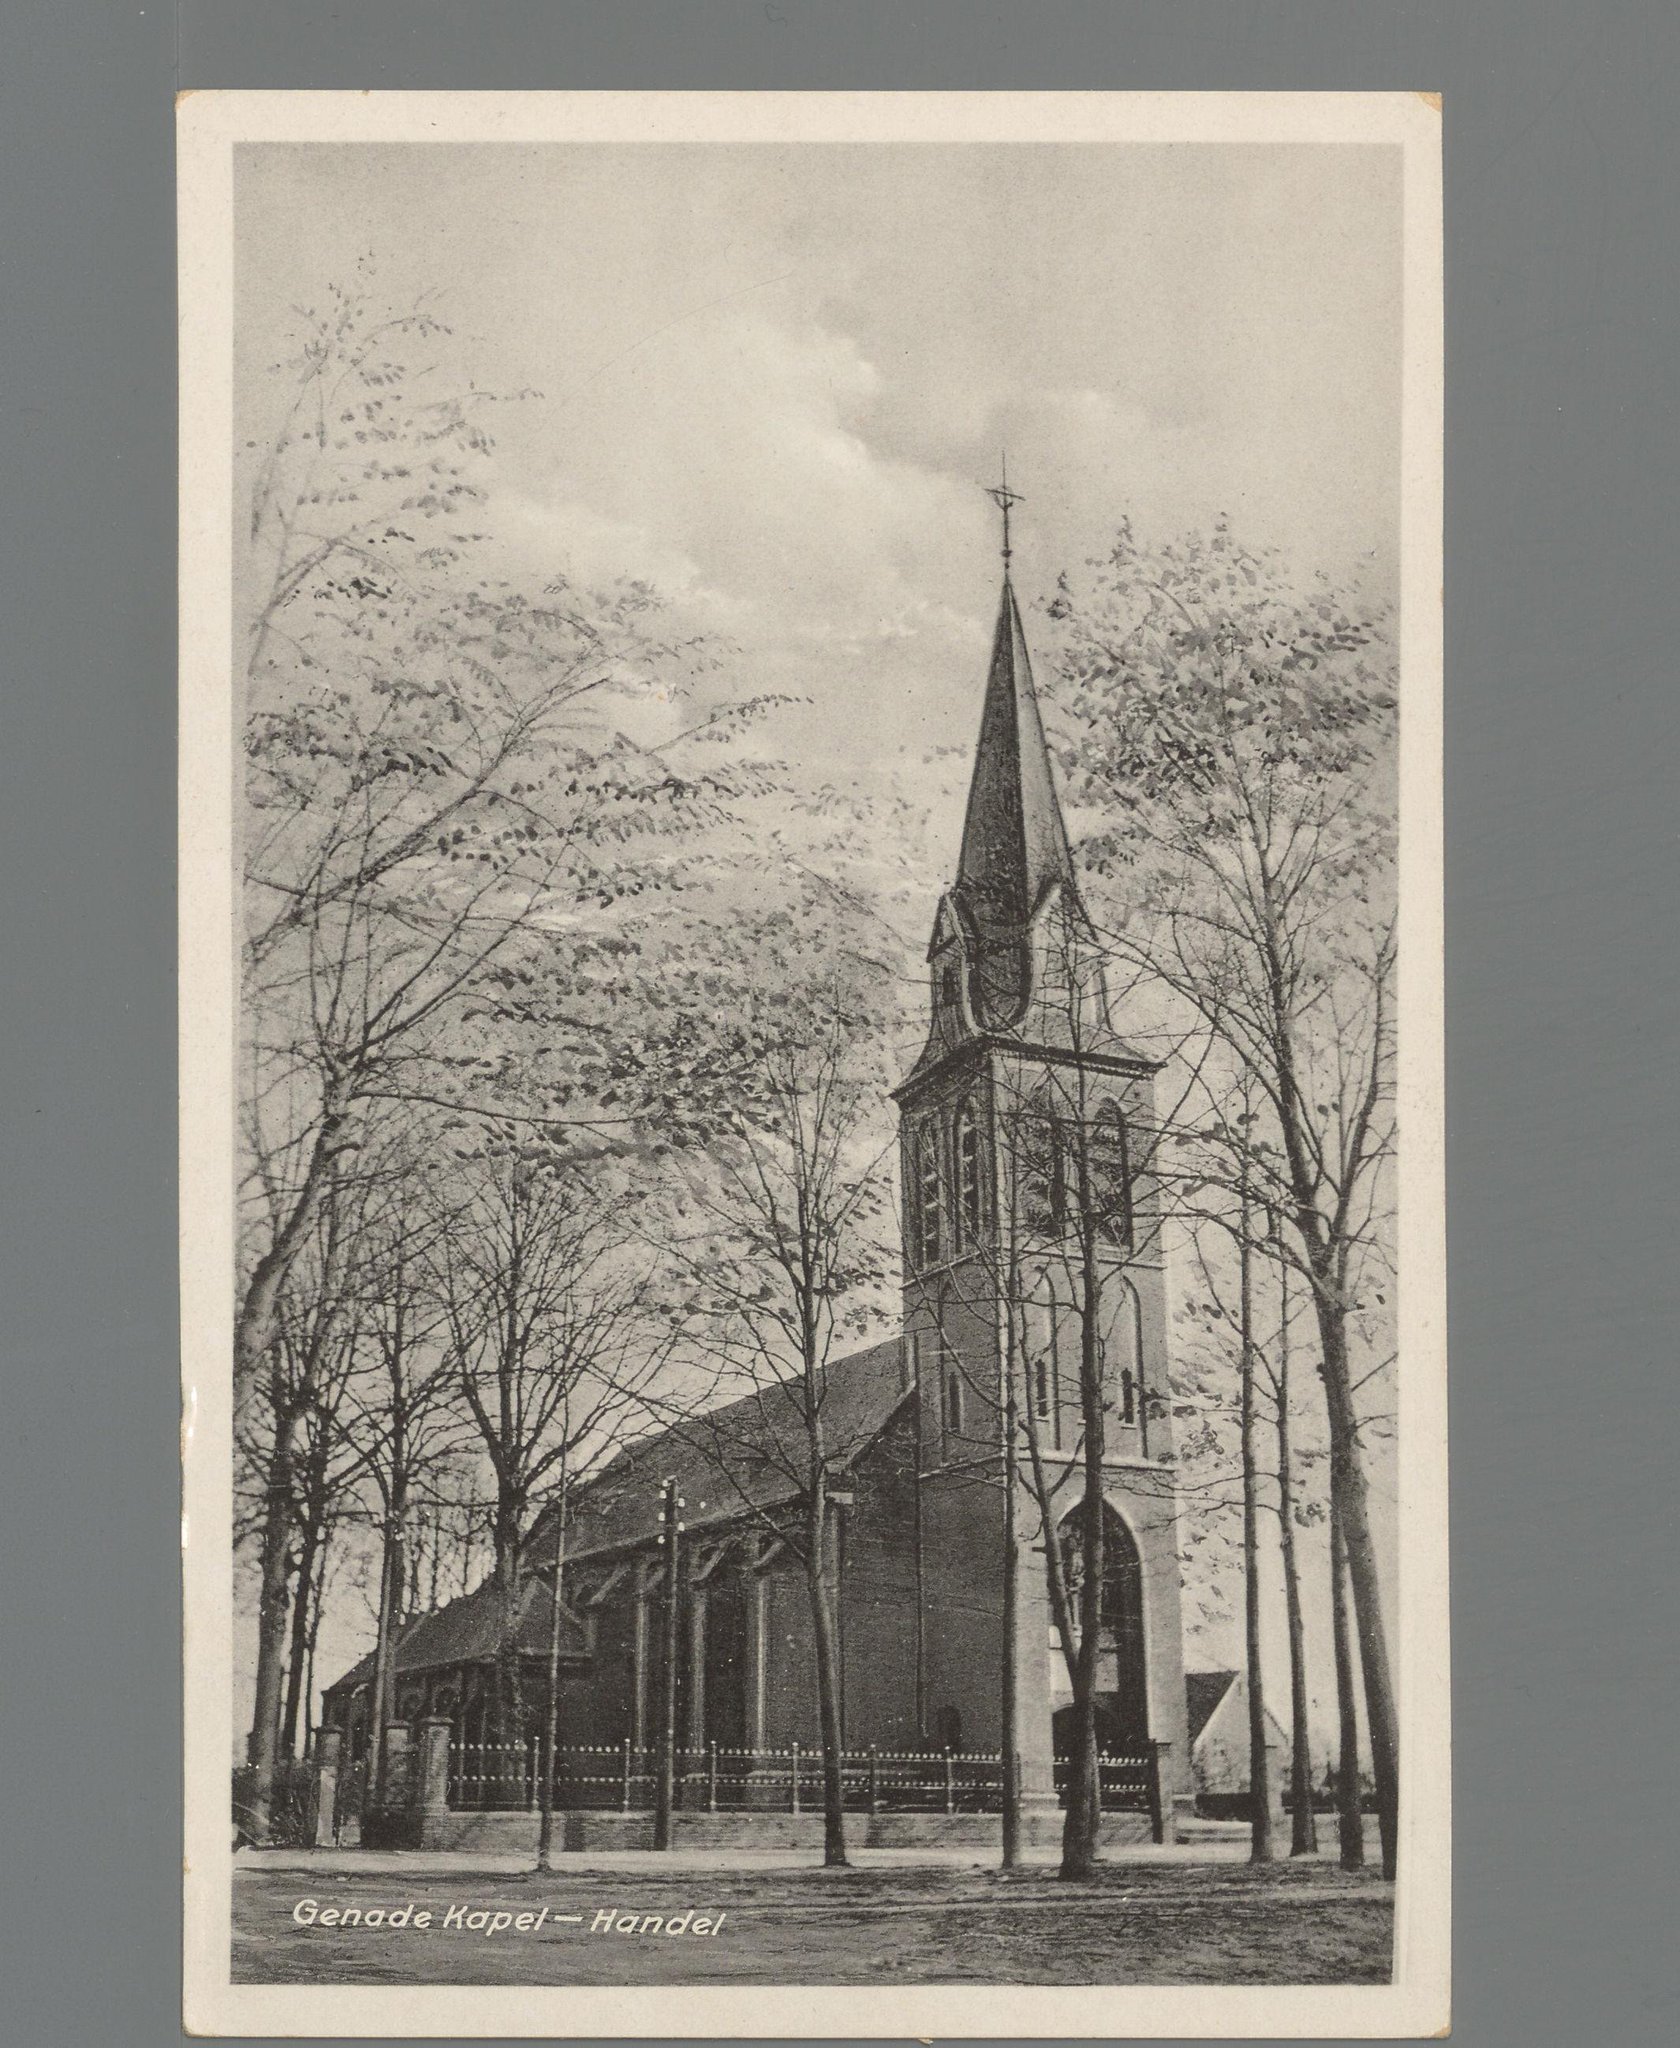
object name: ansichtkaart, prentbriefkaart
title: Genade Kapel - Handel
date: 1913-1950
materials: cardboard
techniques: photograph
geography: handel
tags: church (exterior)